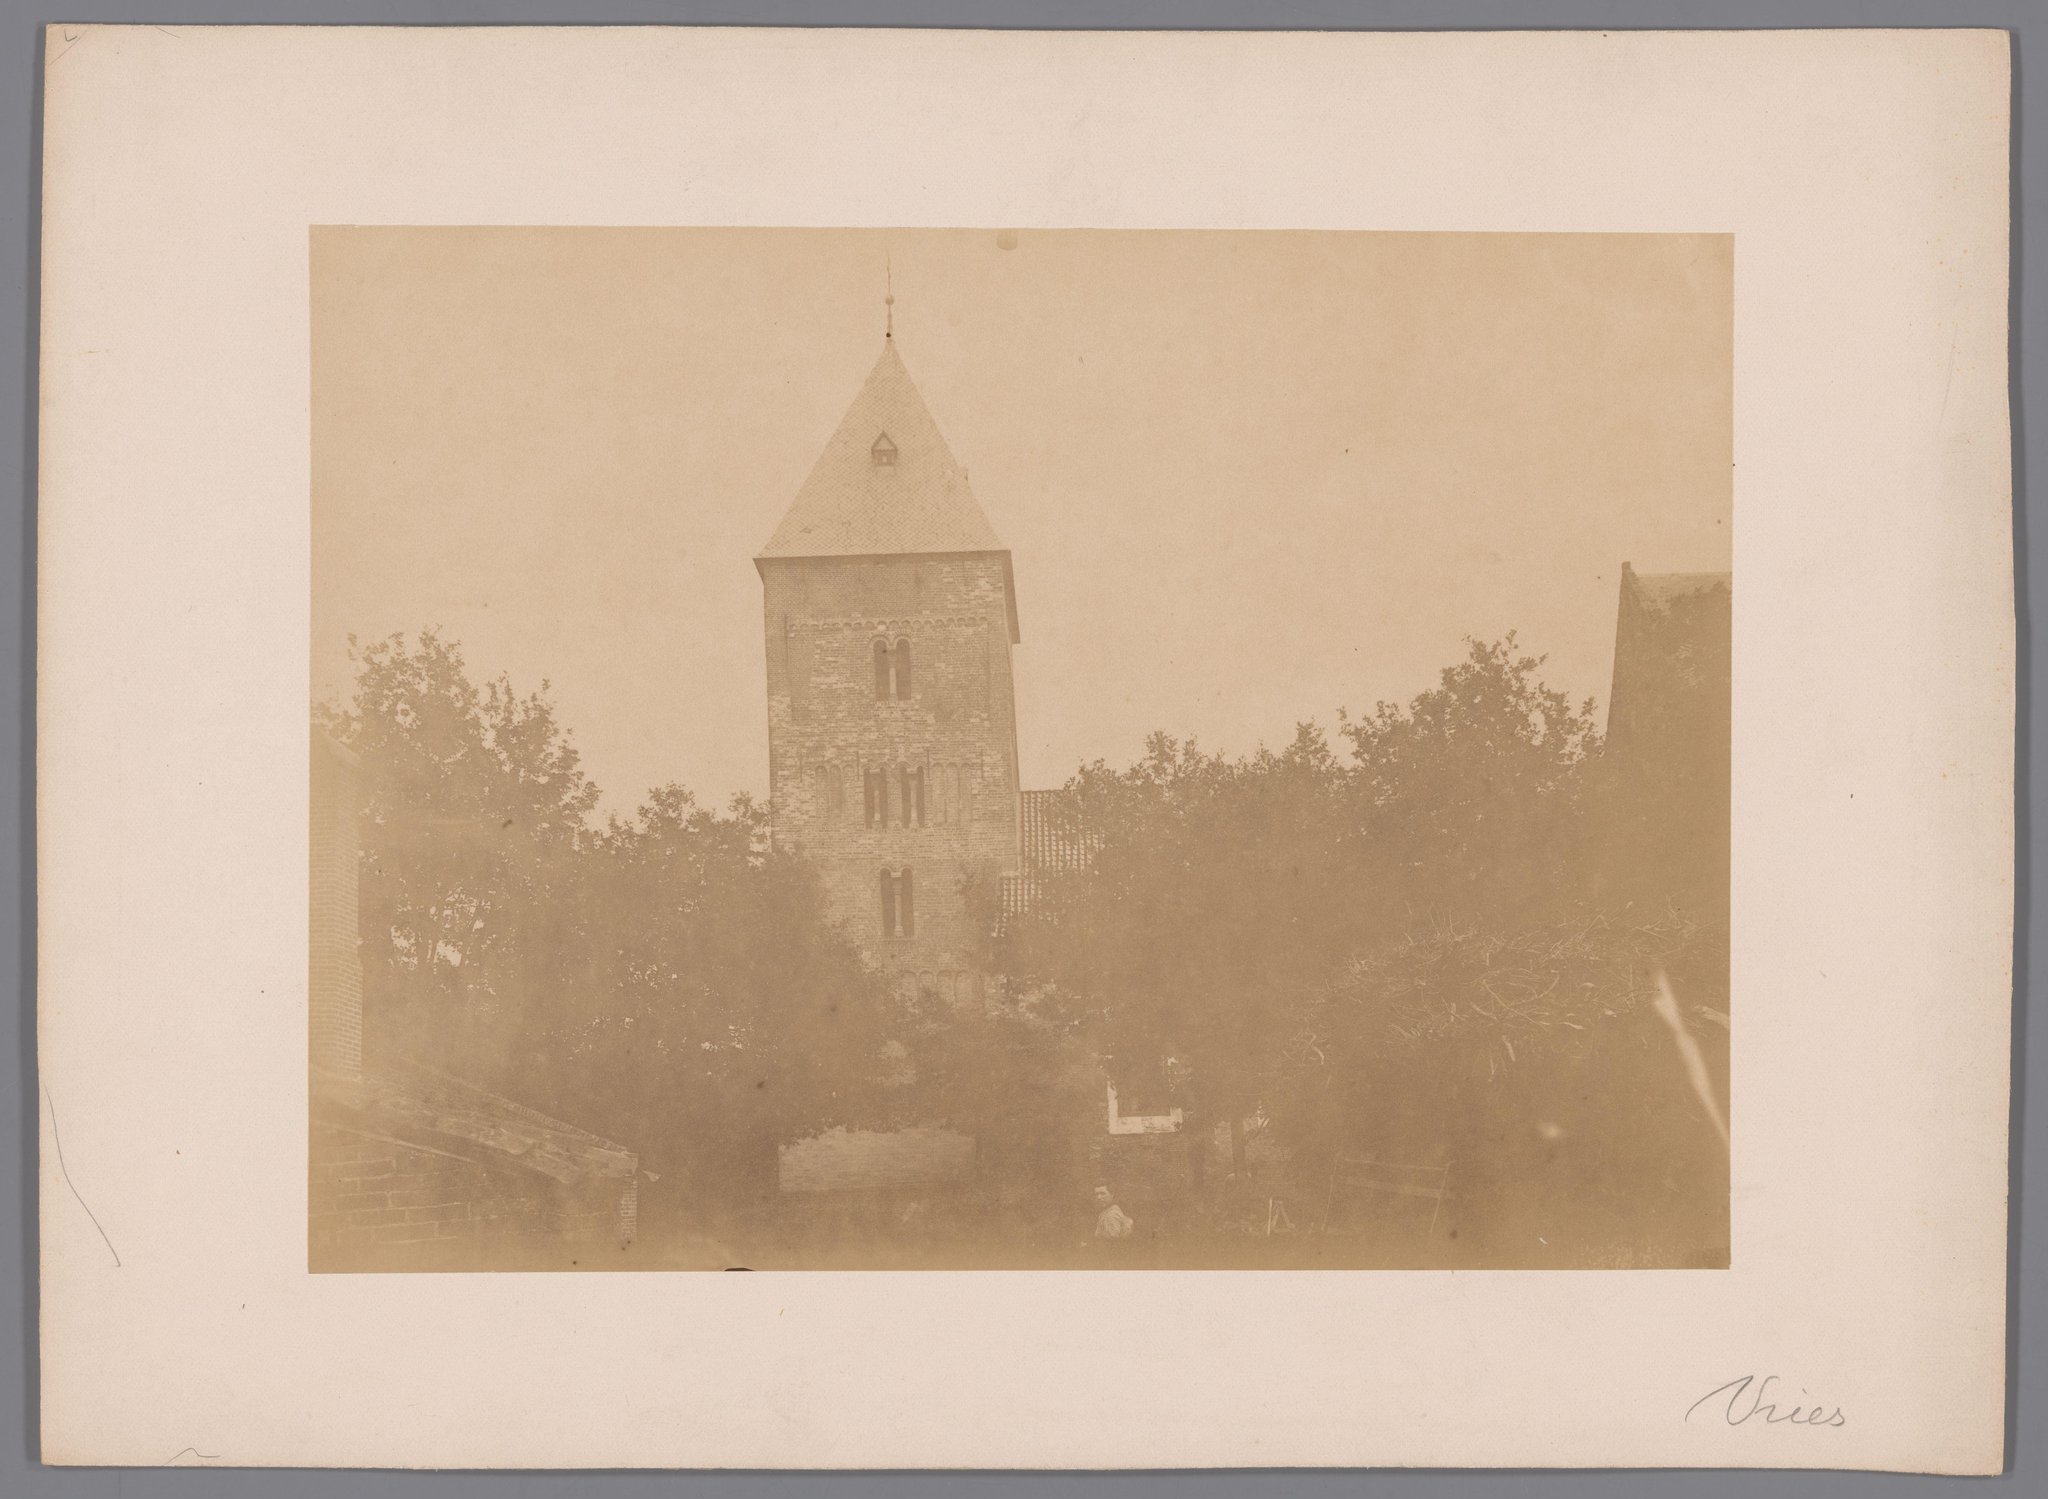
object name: photograph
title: Toren van de Sint-Bonifatiuskerk te Vries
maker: anoniem (monumentenzorg)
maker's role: fotograaf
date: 1898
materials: cardboard, photographic support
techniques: albumen print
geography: vries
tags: parts of church exterior and annexes: tower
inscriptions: annotation: ‘Vries’, annotation: ‘Toren a/d Ned. Herv. Kerk te Vries/ (Drenthe)/ Aug 1898’